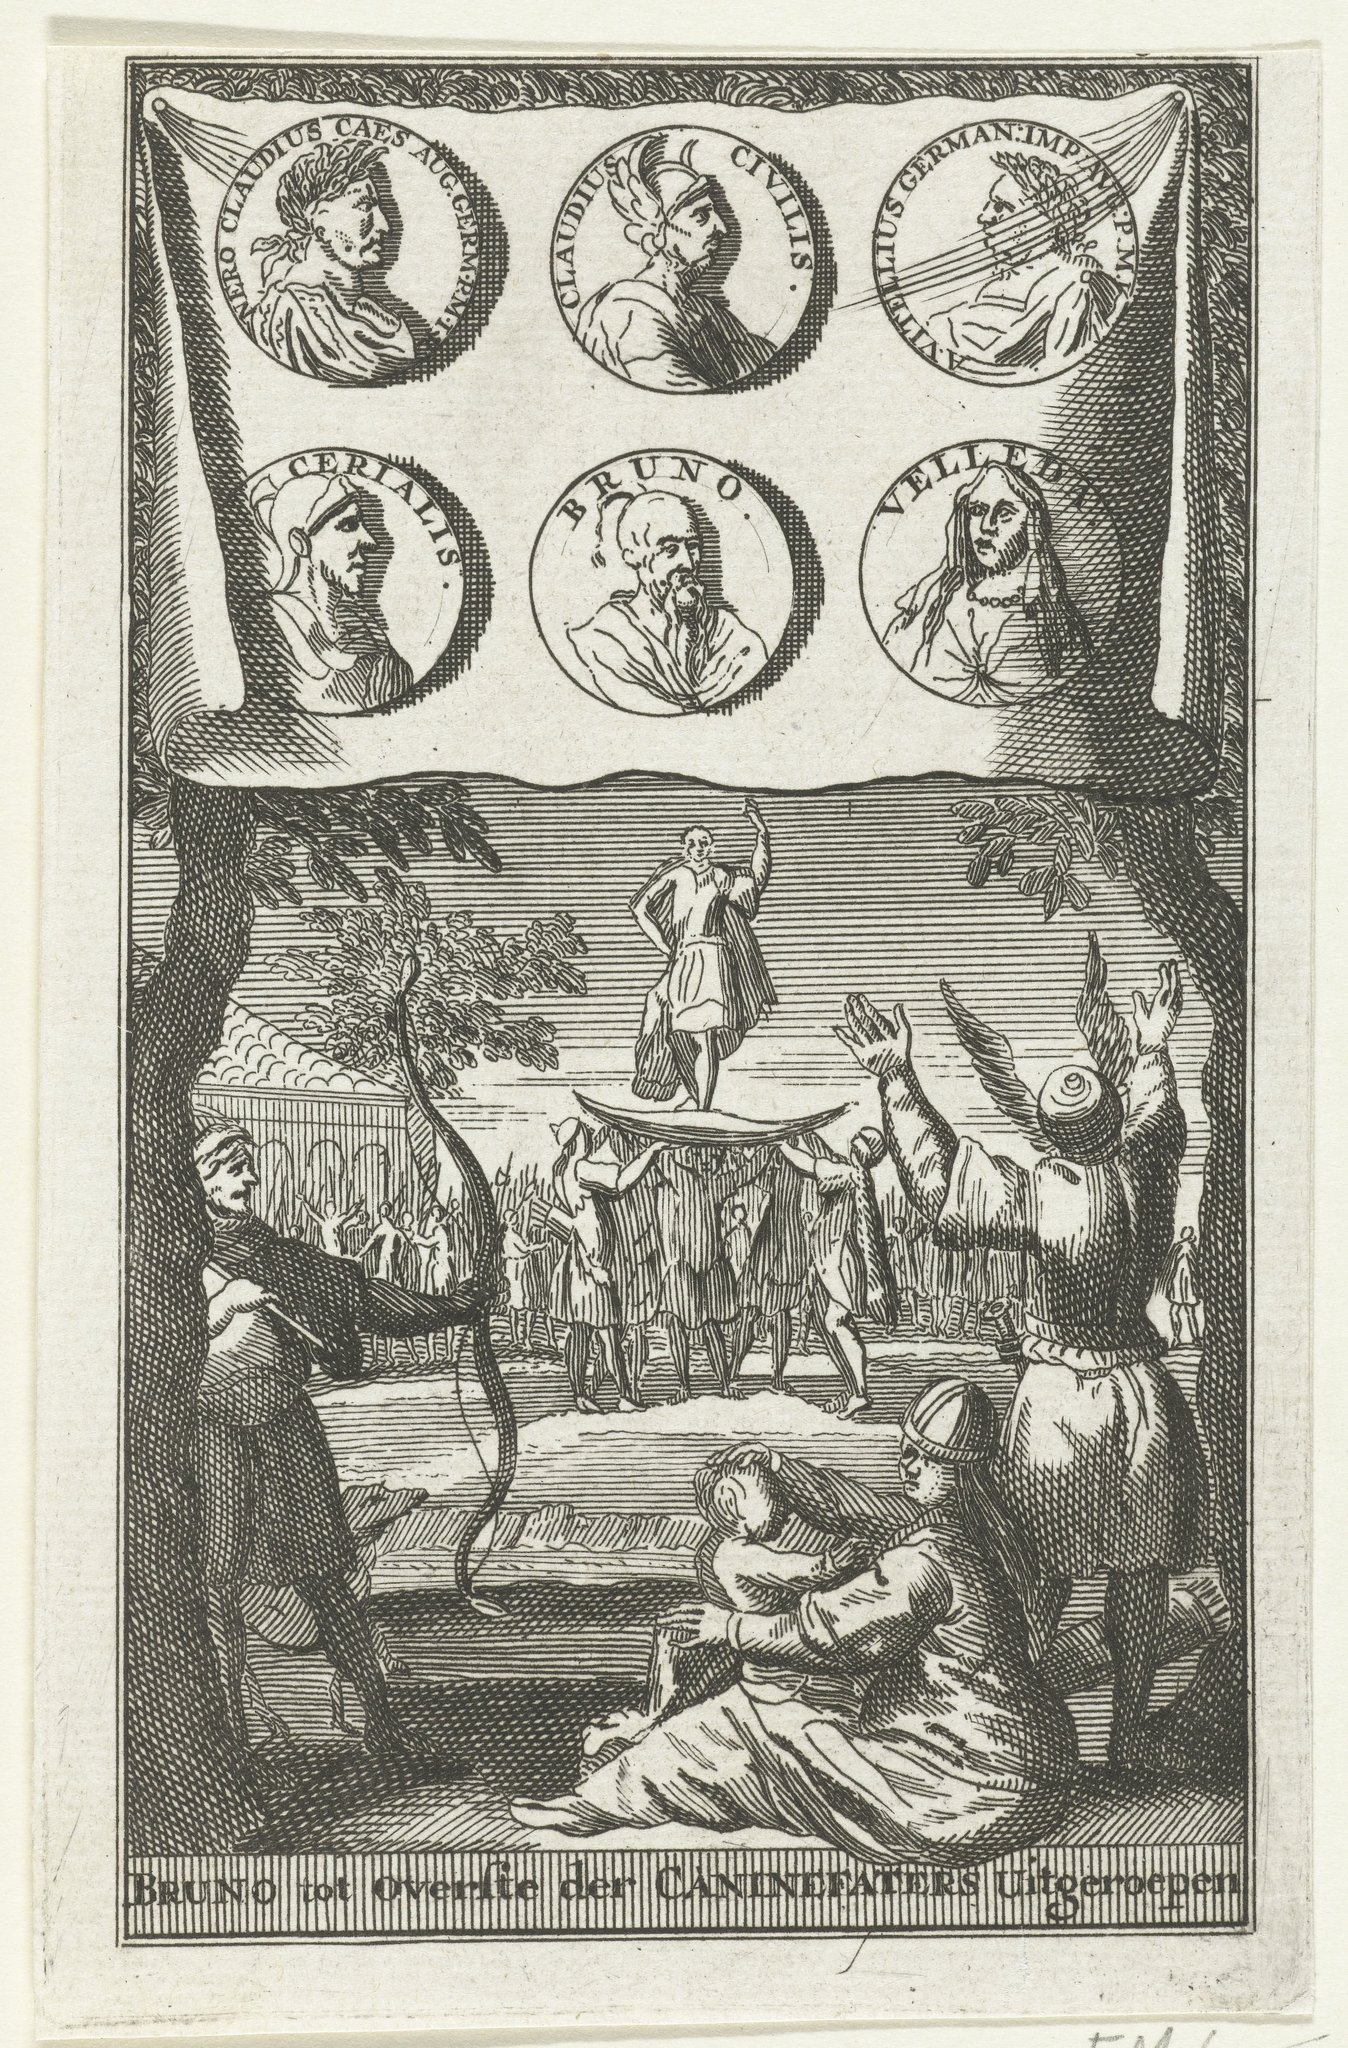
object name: history print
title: Bruno tot Overste der Caninefaters uitgeroepen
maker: pieter van den berge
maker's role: draughtsman, print maker, printer, publisher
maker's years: 1659-1737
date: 1700-1702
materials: paper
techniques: etching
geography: netherlands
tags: brinno, extinct, 'historical' peoples (with name), netherlands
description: Illustratie voor: H. Soeteboom, Oud-heden van Zaan-land, Stavoren, Vronen en Waterland : deze laatste druk ... met nodige aanteekeningen, figuren, en een landkaart verrykt / Saan-Landse Arcadia, W. Linnig van Koppenol, Amsterdam 1702, dl. 1, ingebonden tussen p. 38/39.